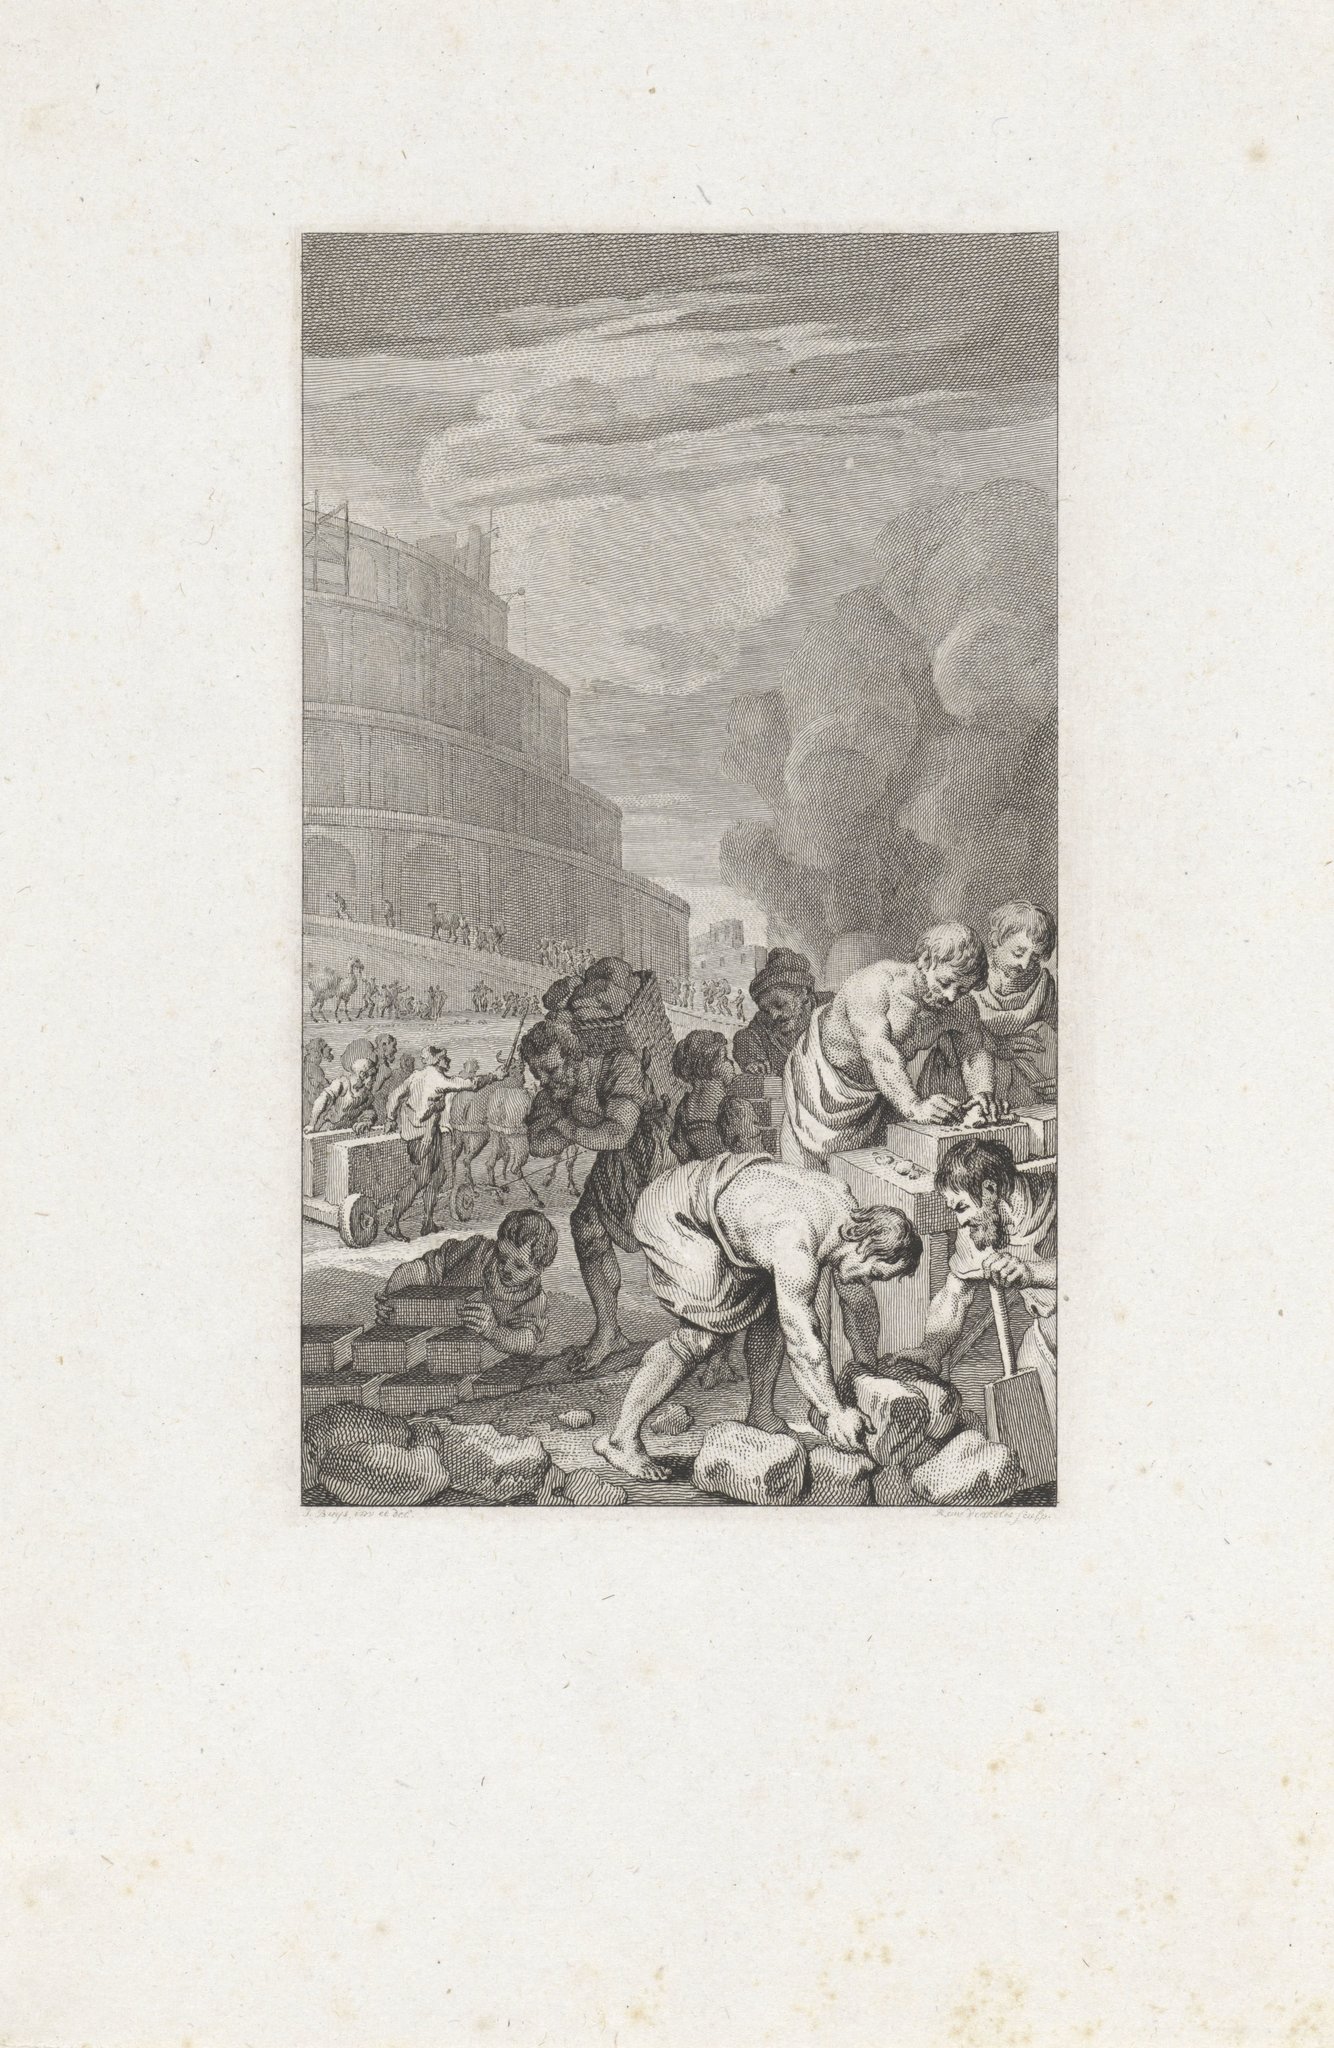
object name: print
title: Bouw van de toren van Babel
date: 1793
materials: paper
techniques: engraving, etching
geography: amsterdam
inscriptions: collector's mark: Lugt 240